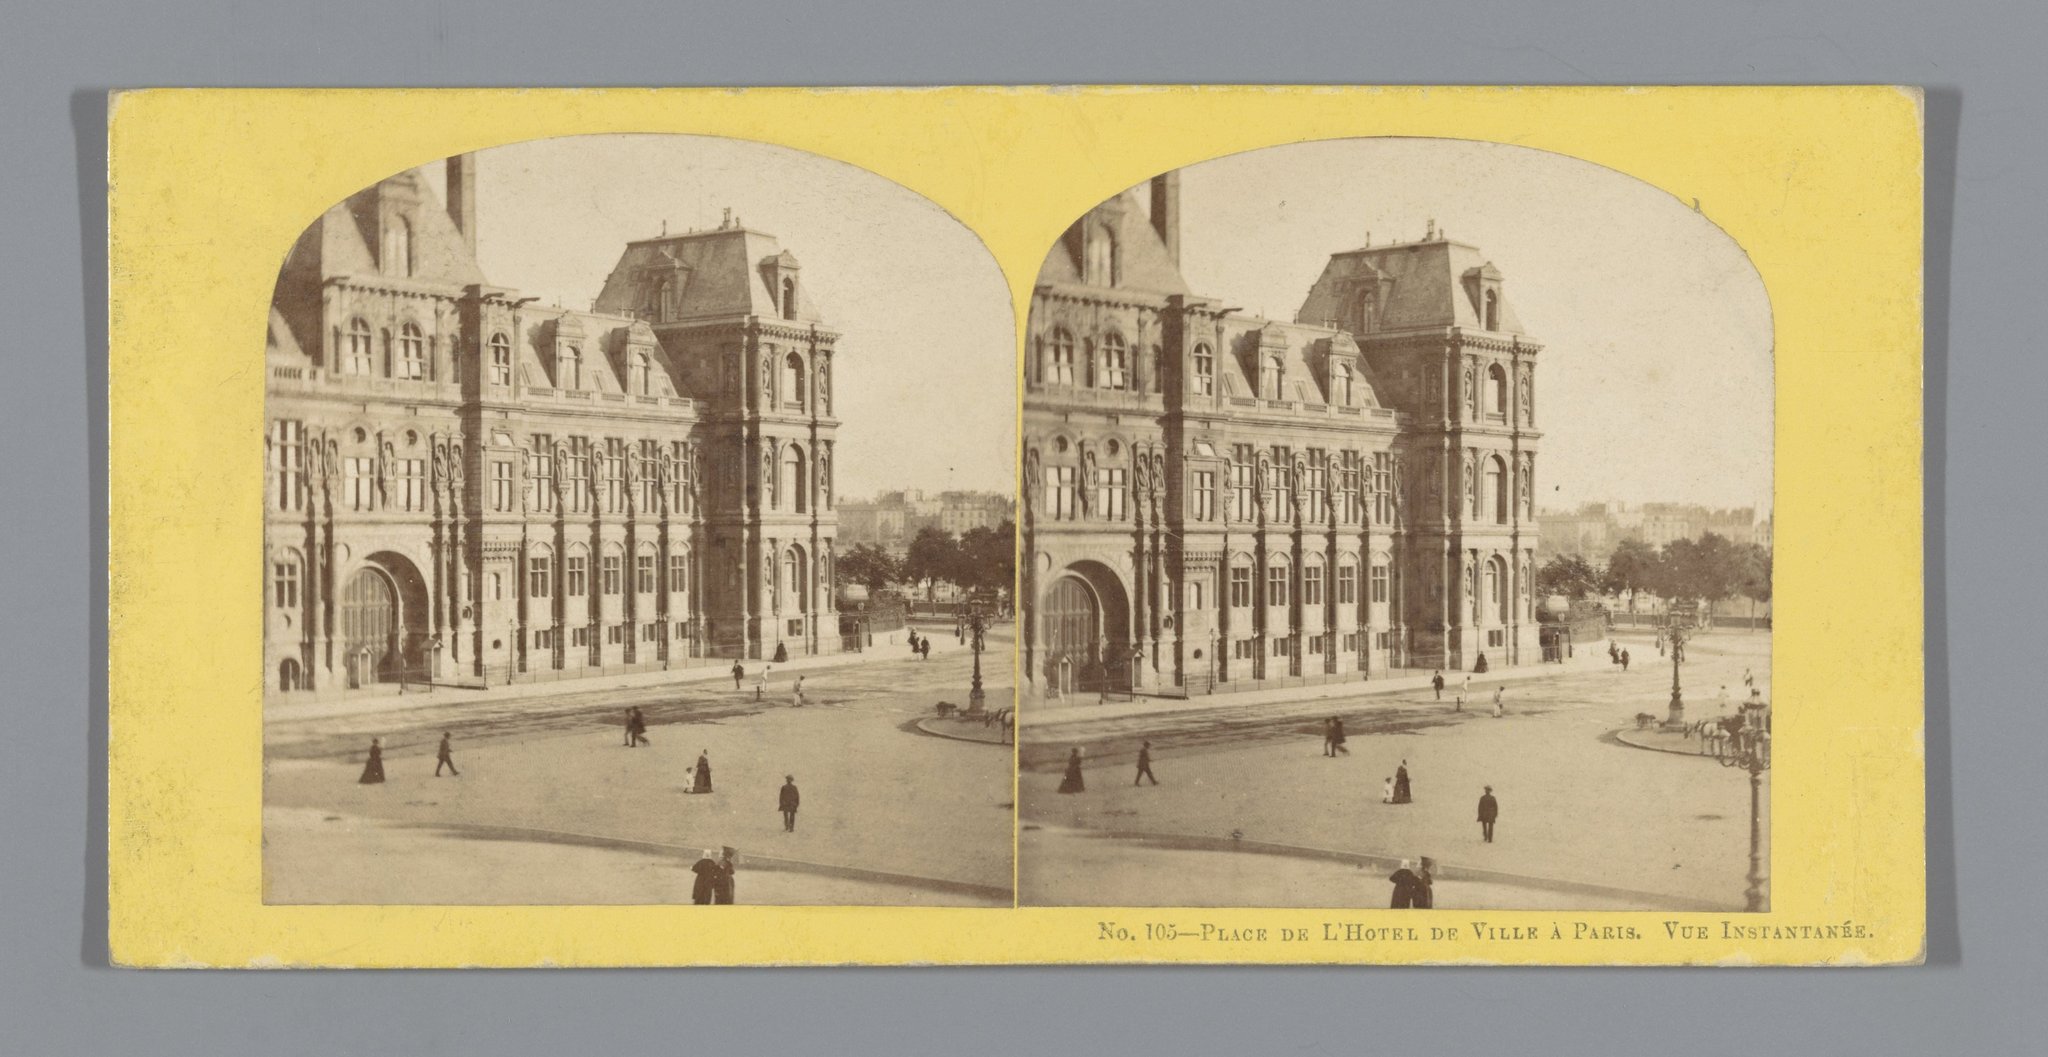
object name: stereograph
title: Gezicht op de Place de l'Hôtel-de-Ville te Parijs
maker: Anonymous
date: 1850-1875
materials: cardboard, photographic support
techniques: albumen print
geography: paris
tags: square, place, circus, etc., townhall, façade (of house or building)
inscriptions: number: ‘No. 105’